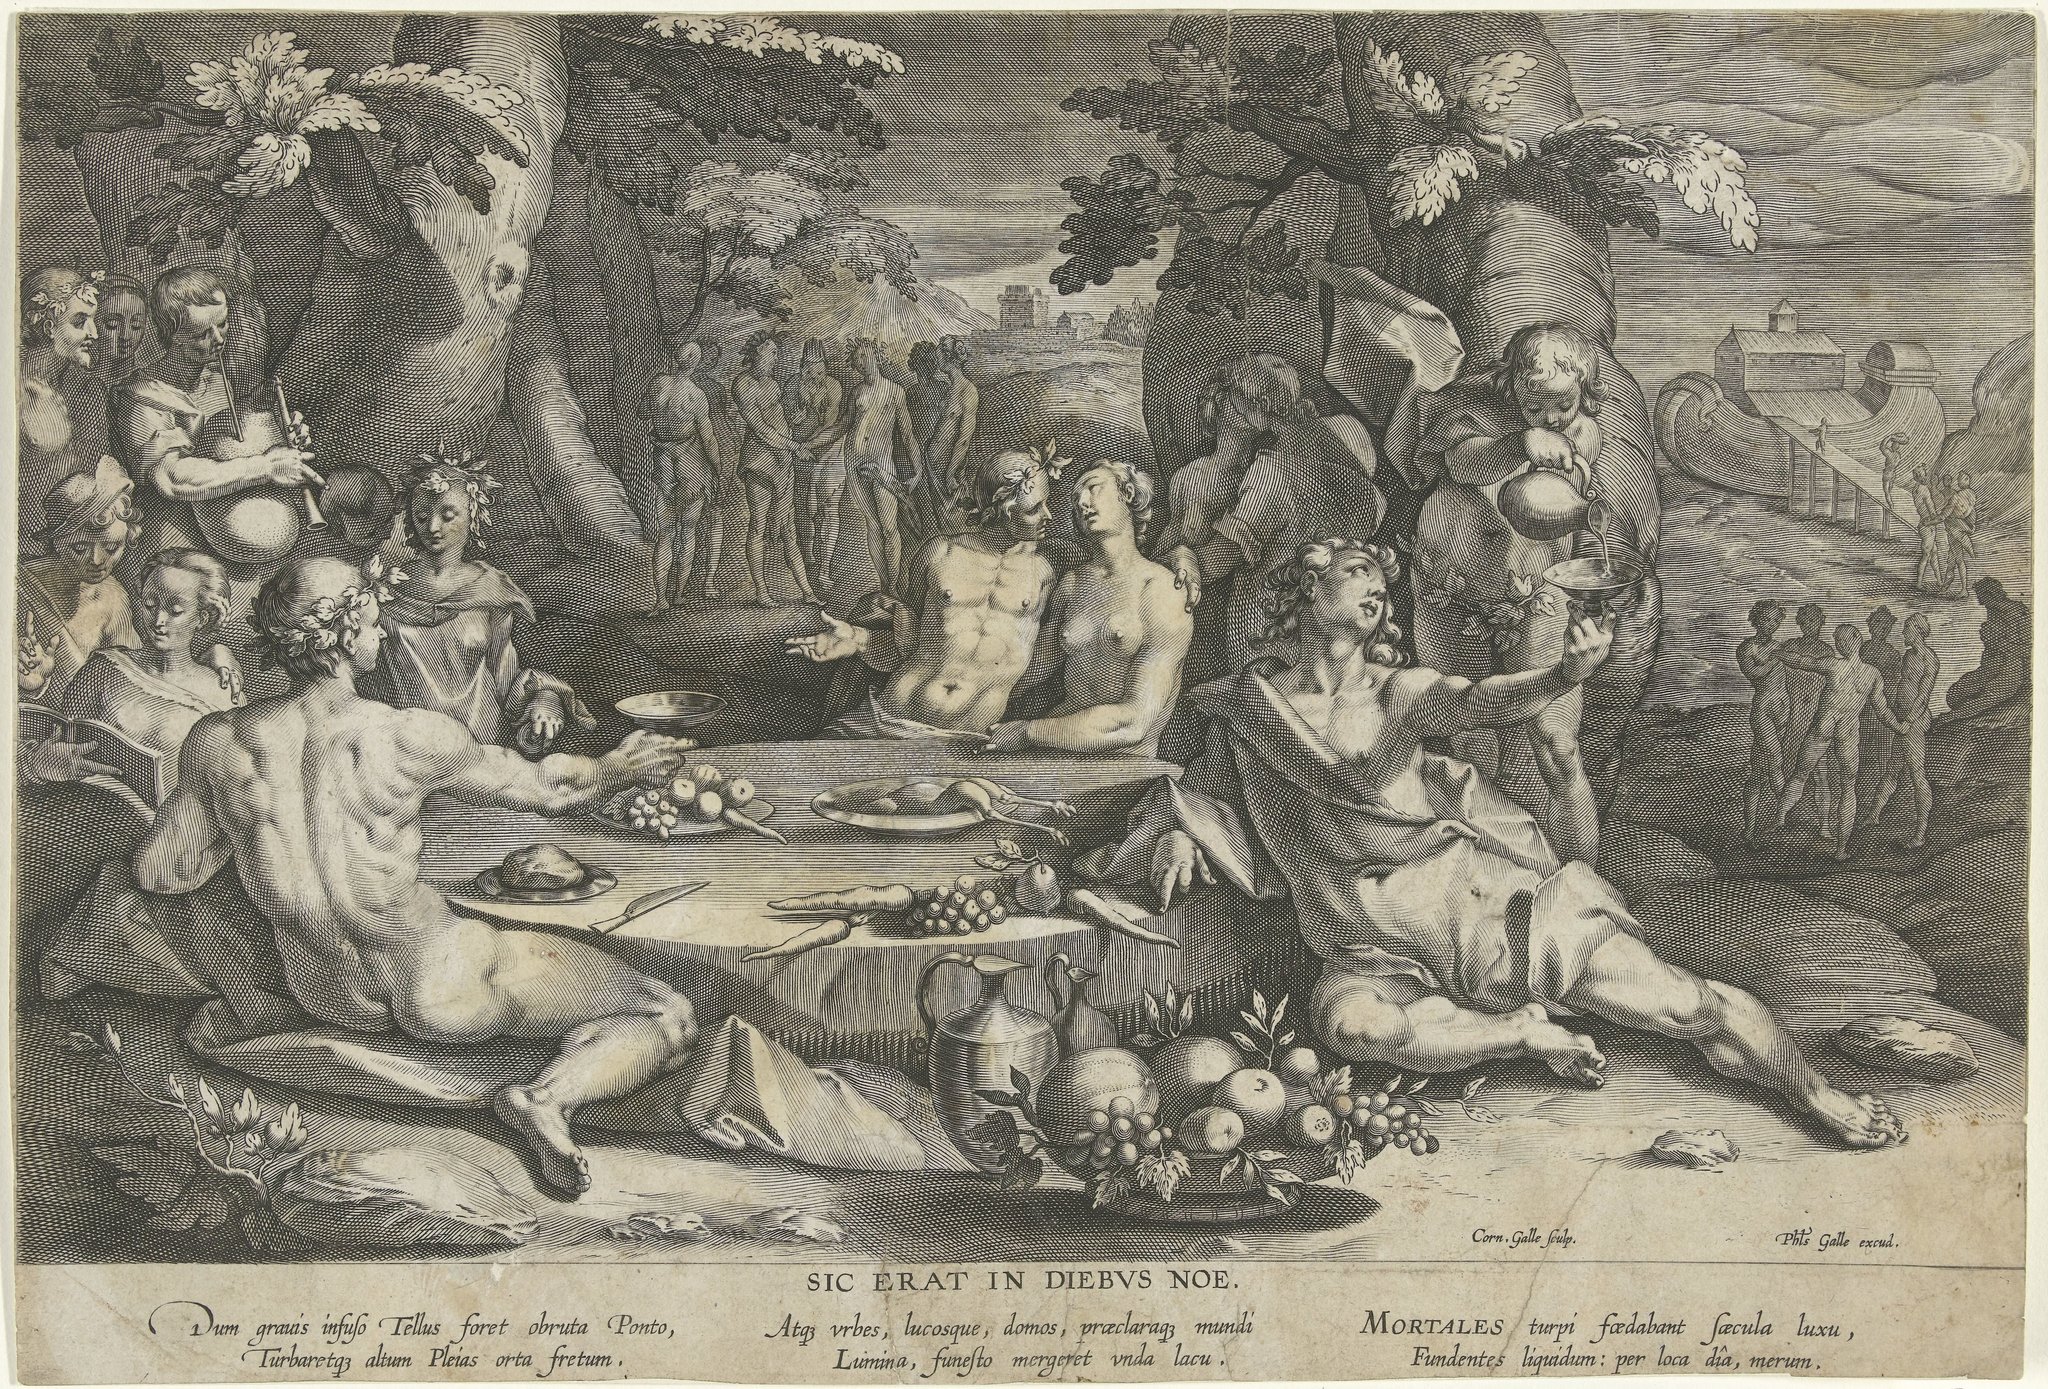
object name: print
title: Sic erat in diebus Noe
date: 1586-1612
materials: paper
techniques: engraving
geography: antwerp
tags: the wickedness of mankind; the wicked are usually shown feasting and revelling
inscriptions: collector's mark: Lugt 2228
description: Jonge mensen genieten van een banket in de openlucht. Halfnaakte mannen en vrouwen zitten aan een lage ronde tafel, drinken wijn en vrijen. Links speelt een man op een doedelzak. Rechts op de achtergrond is de ark van Noach te zien. De straf voor het zondige leven van de jeugd is de zondvloed.